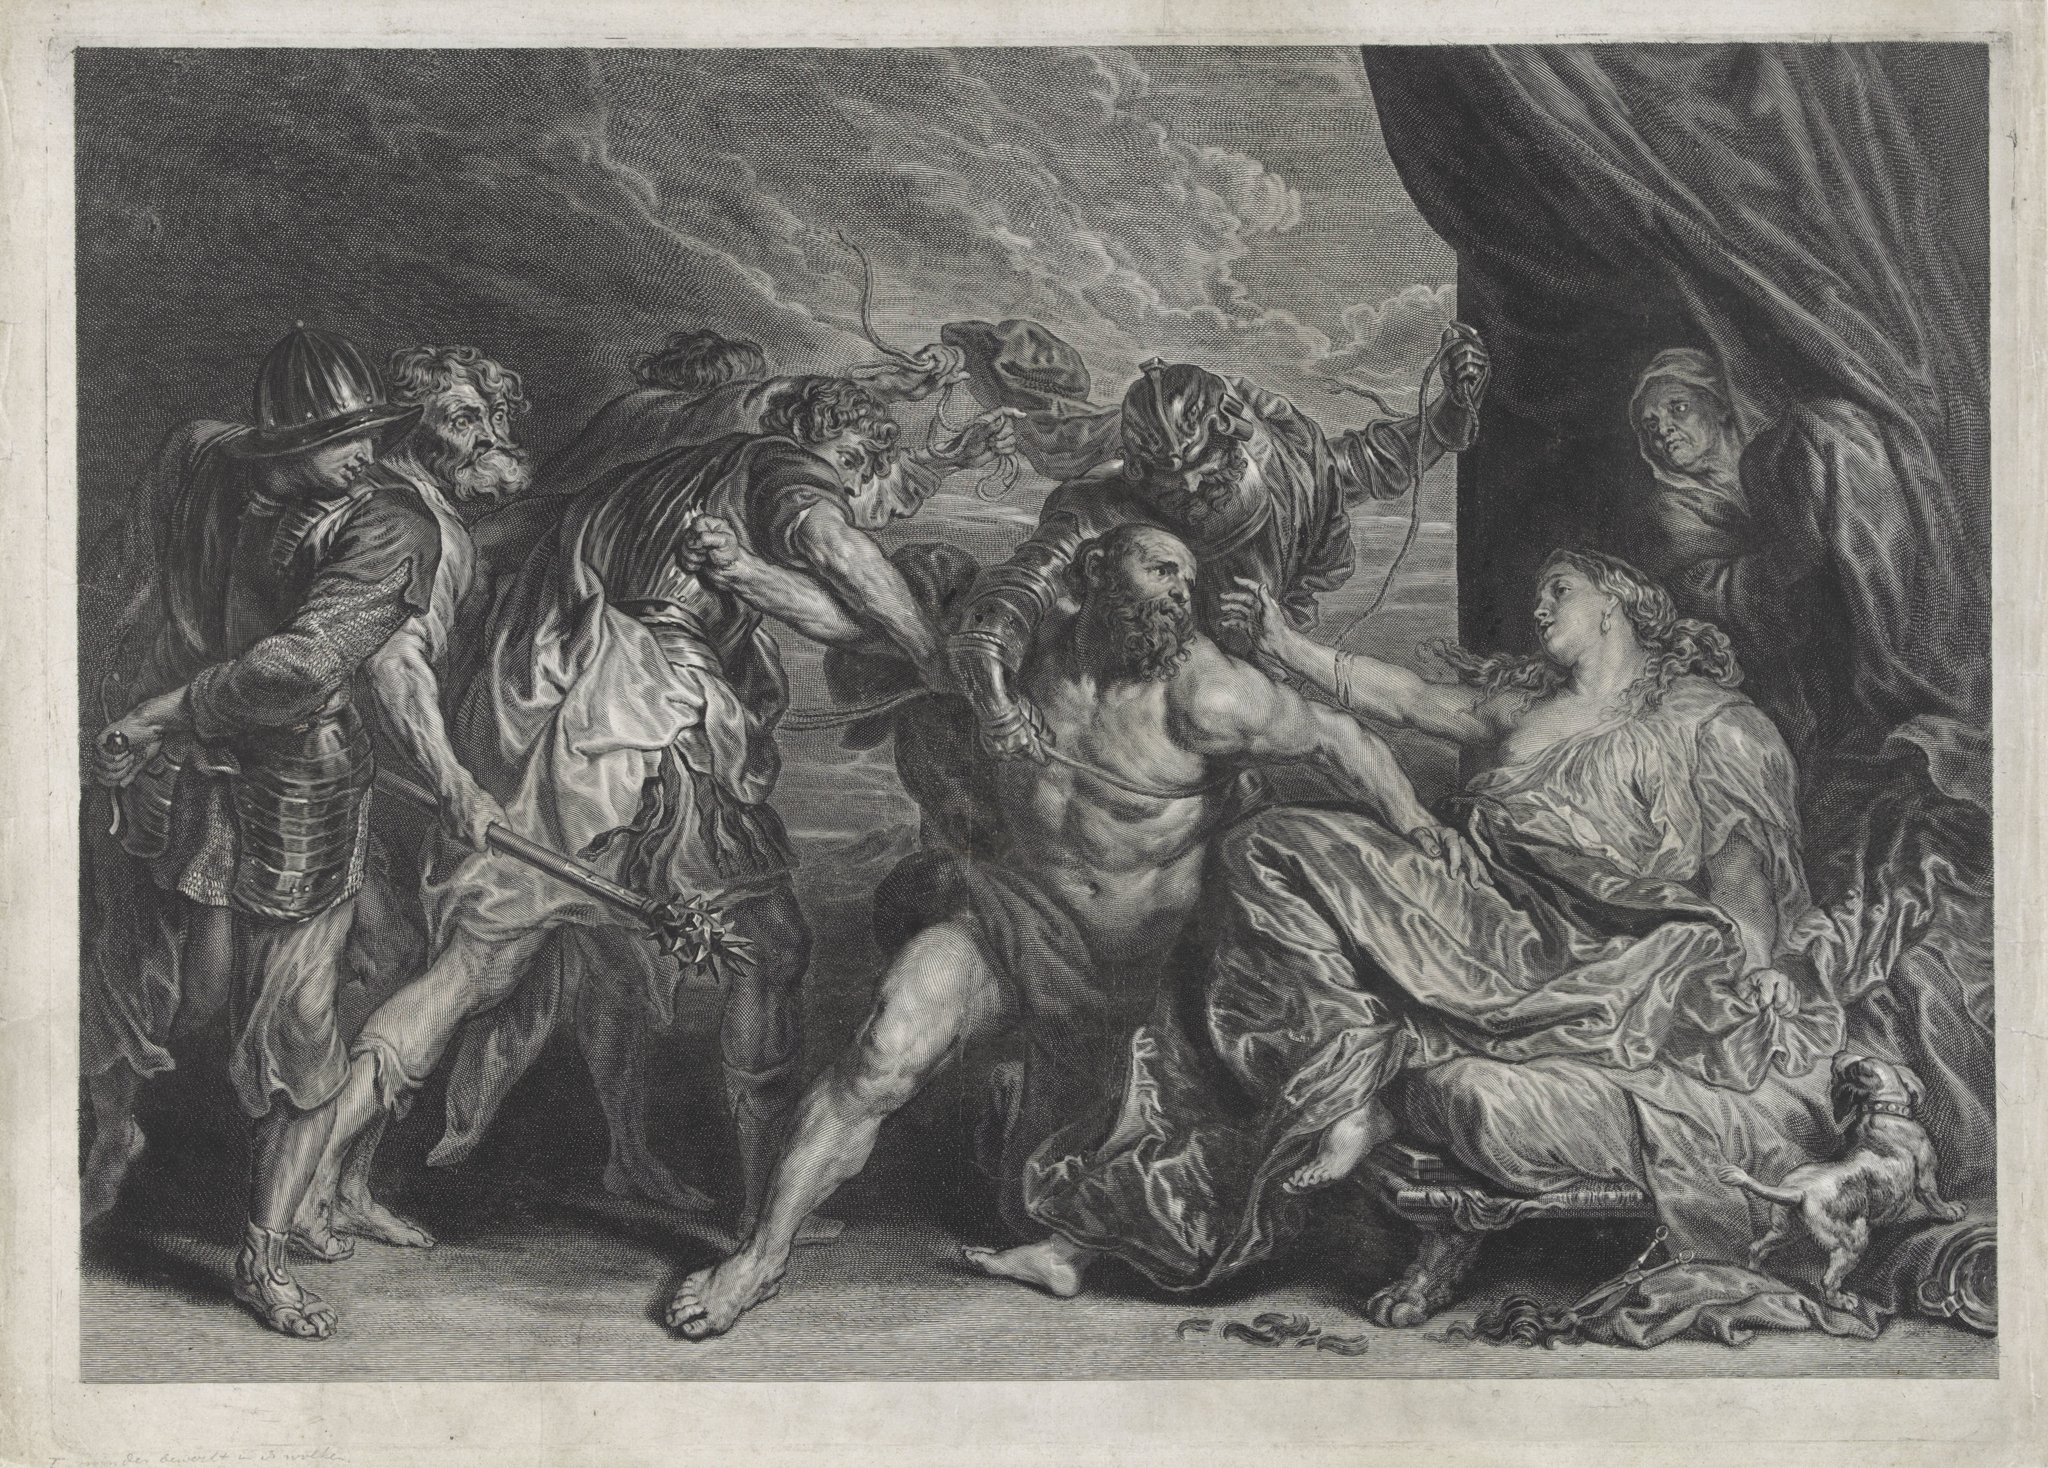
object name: print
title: Simson en Delila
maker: hendrik snyers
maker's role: print maker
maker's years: 1611-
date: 1643-1648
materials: paper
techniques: engraving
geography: antwerp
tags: samson wakes up and finds his hair and strength gone; he is taken prisoner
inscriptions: collector's mark: Lugt 240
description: Soldaten nemen Simson gevangen nadat hij bij Delila geslapen heeft en zijn haren door een Filistijn zijn afgeknipt.